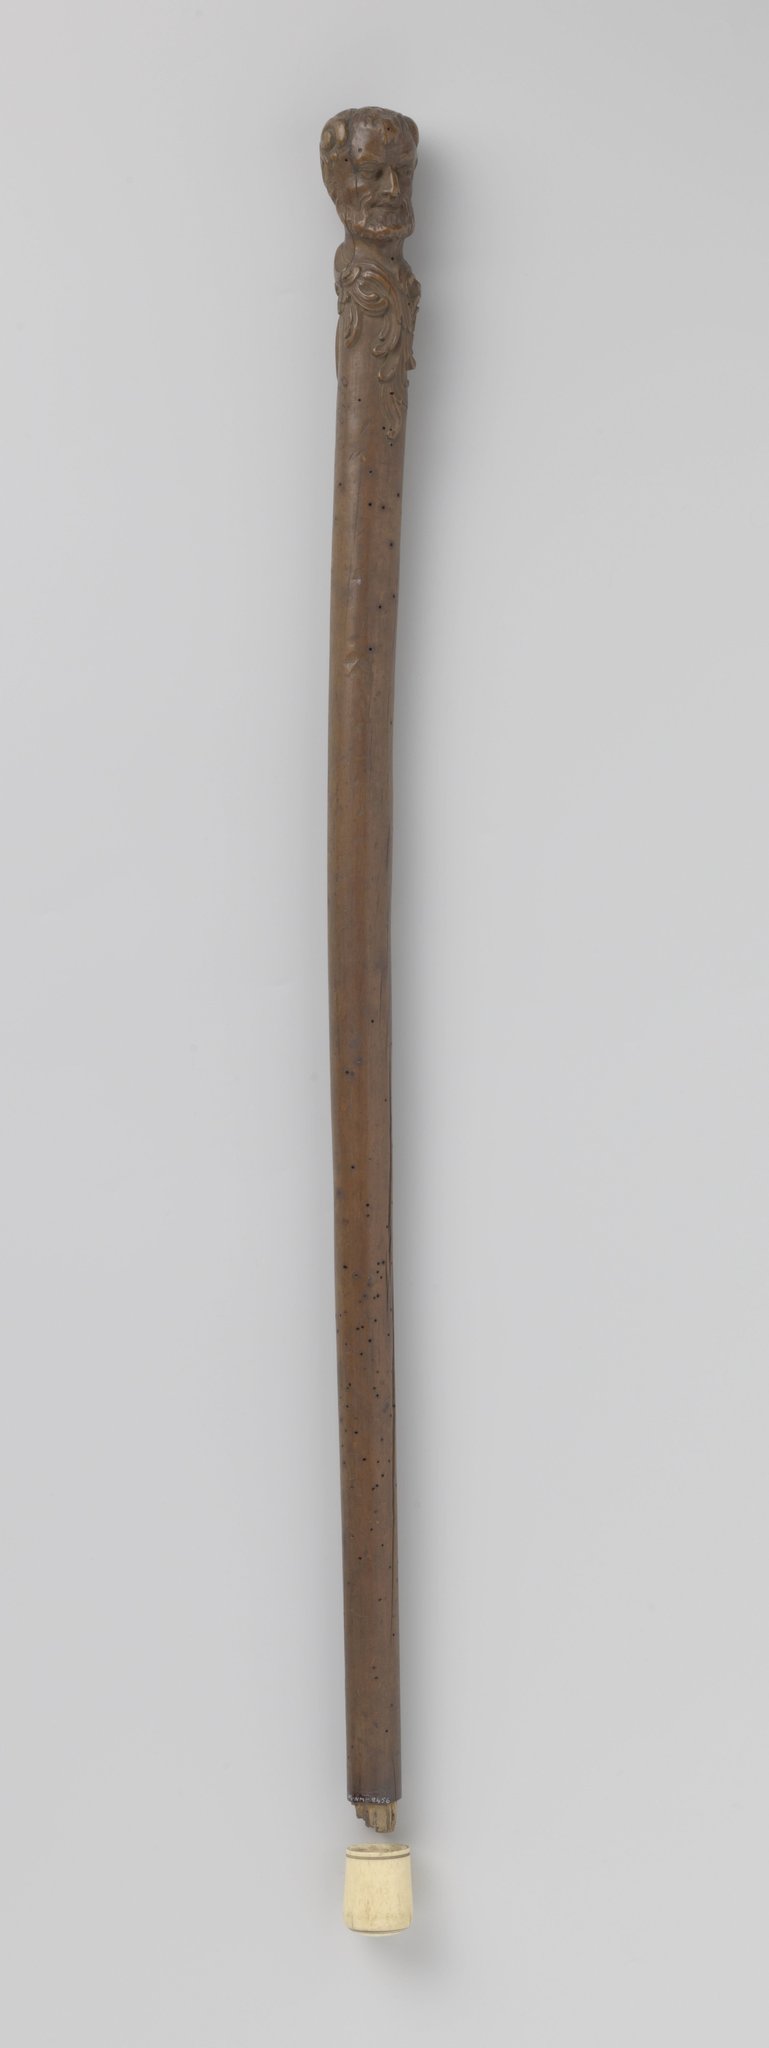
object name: womenswear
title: Wandelstok van hout met saterkop op knop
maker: Anonymous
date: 1700-1750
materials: wood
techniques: cutting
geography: europe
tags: friesland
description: Wandelstok van ijzerhout (?). De knop bestaat uit een gesneden saterkop met de stok verbonden door een ornament.